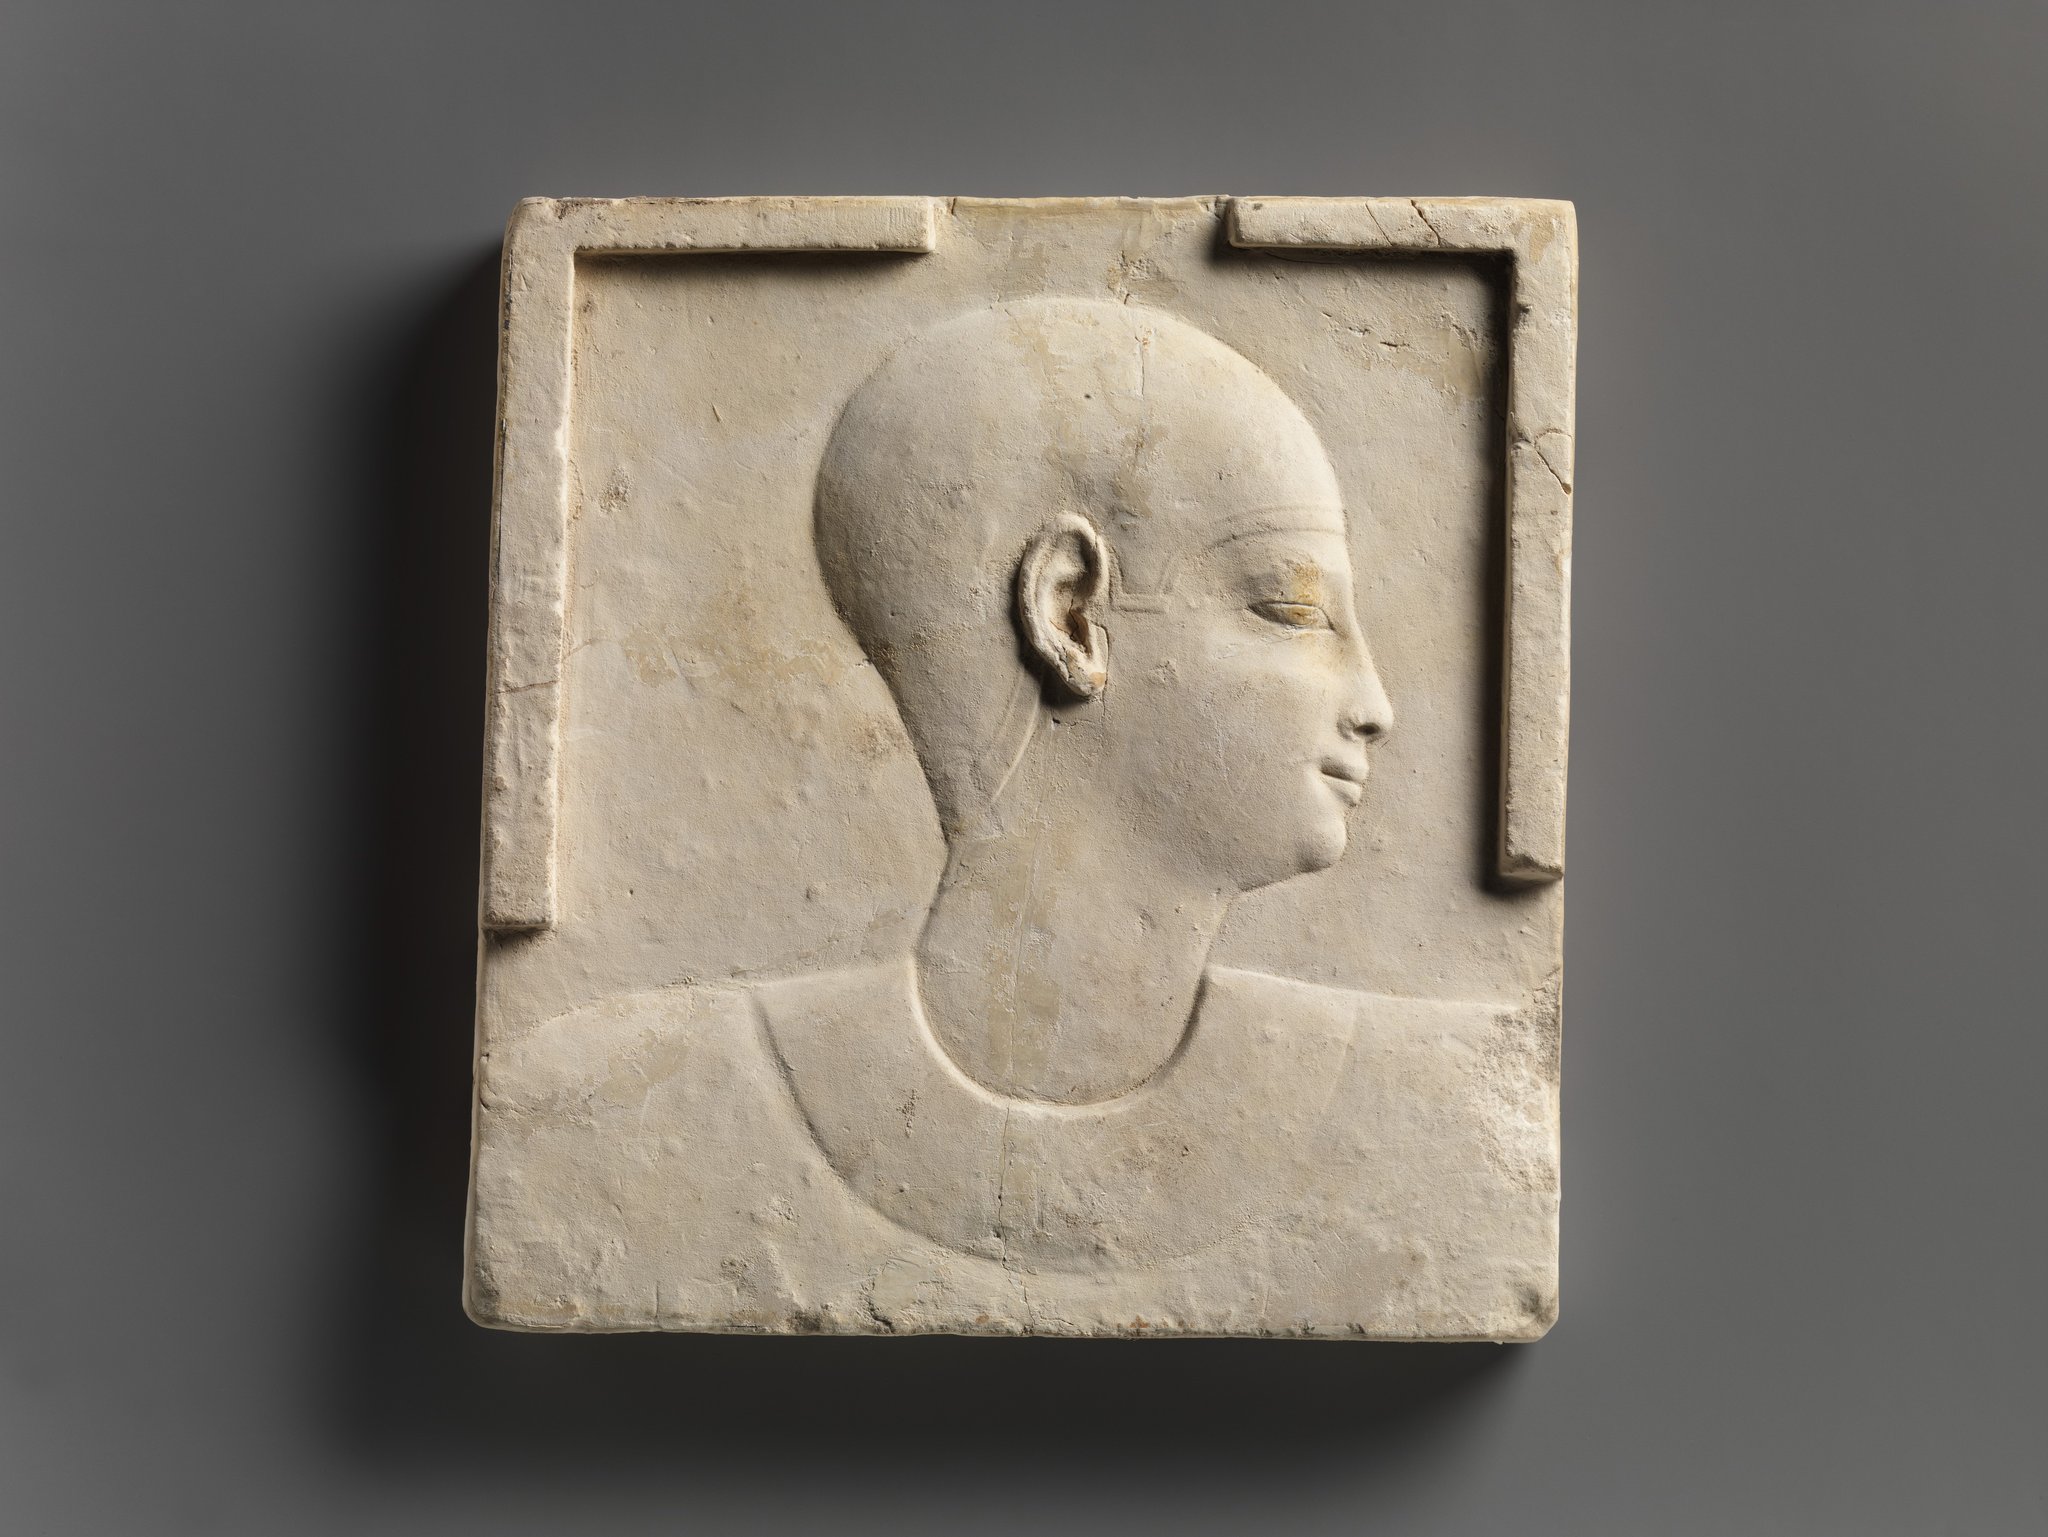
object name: sculptor's model votive, priest, opposite side priest, crocodile god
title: Plaque with head and shoulders of a priestly figure, opposite side head of priestly figure and most of a figure of crocodile-headed god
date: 400-30 BCE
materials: limestone, paint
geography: egypt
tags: men